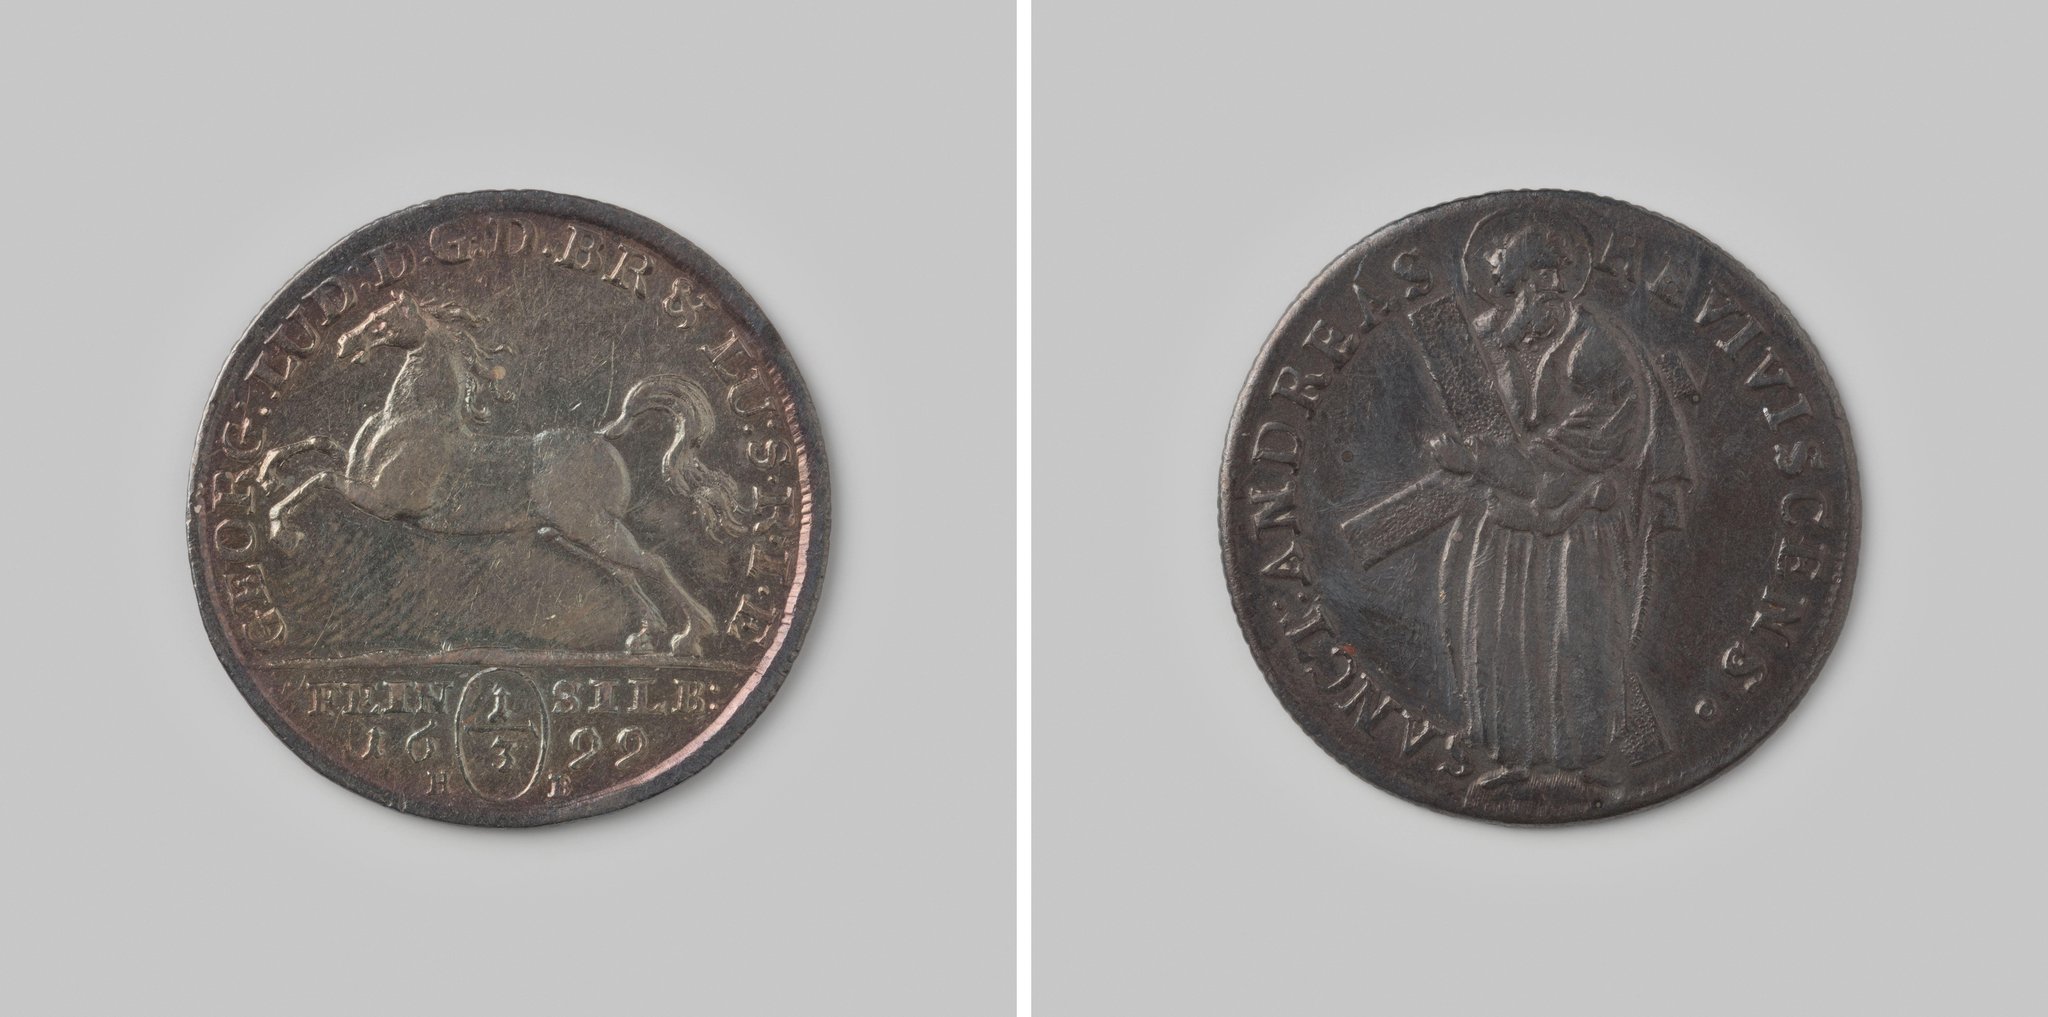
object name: coin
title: Derde taler uit Brunswijk-Luneburg-Calenberg-Hannover van Georg I Ludwig,1699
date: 1699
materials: silver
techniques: striking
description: Zilveren munt. Voorzijde: springend paard naar links. In afsnede waarde-aanduiding en jaartal. Keerzijde: heilige Andreas met kruis. Kabelrand.